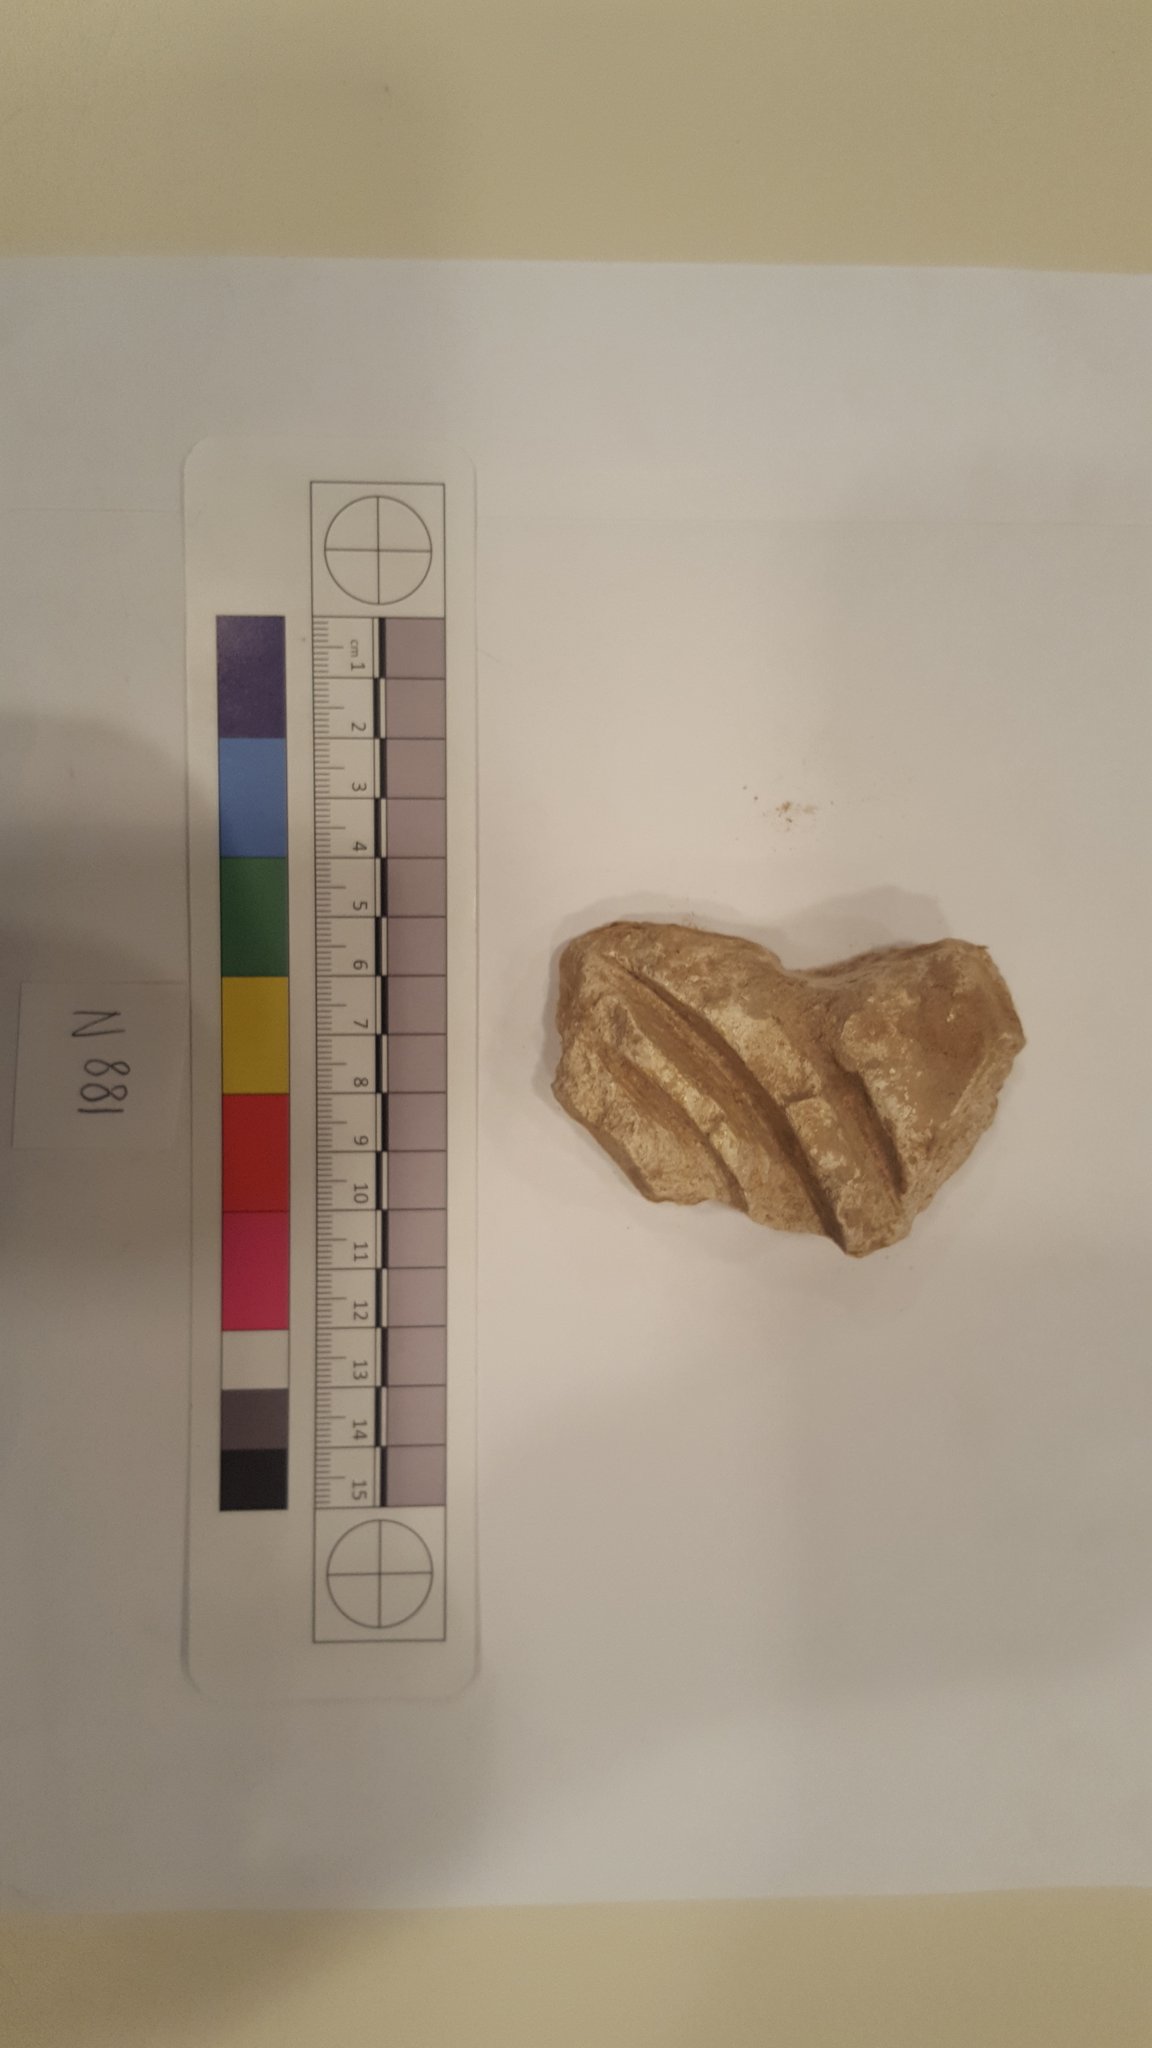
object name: fragment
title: Stucco Fragment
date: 701-1200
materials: plaster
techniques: carving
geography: iran